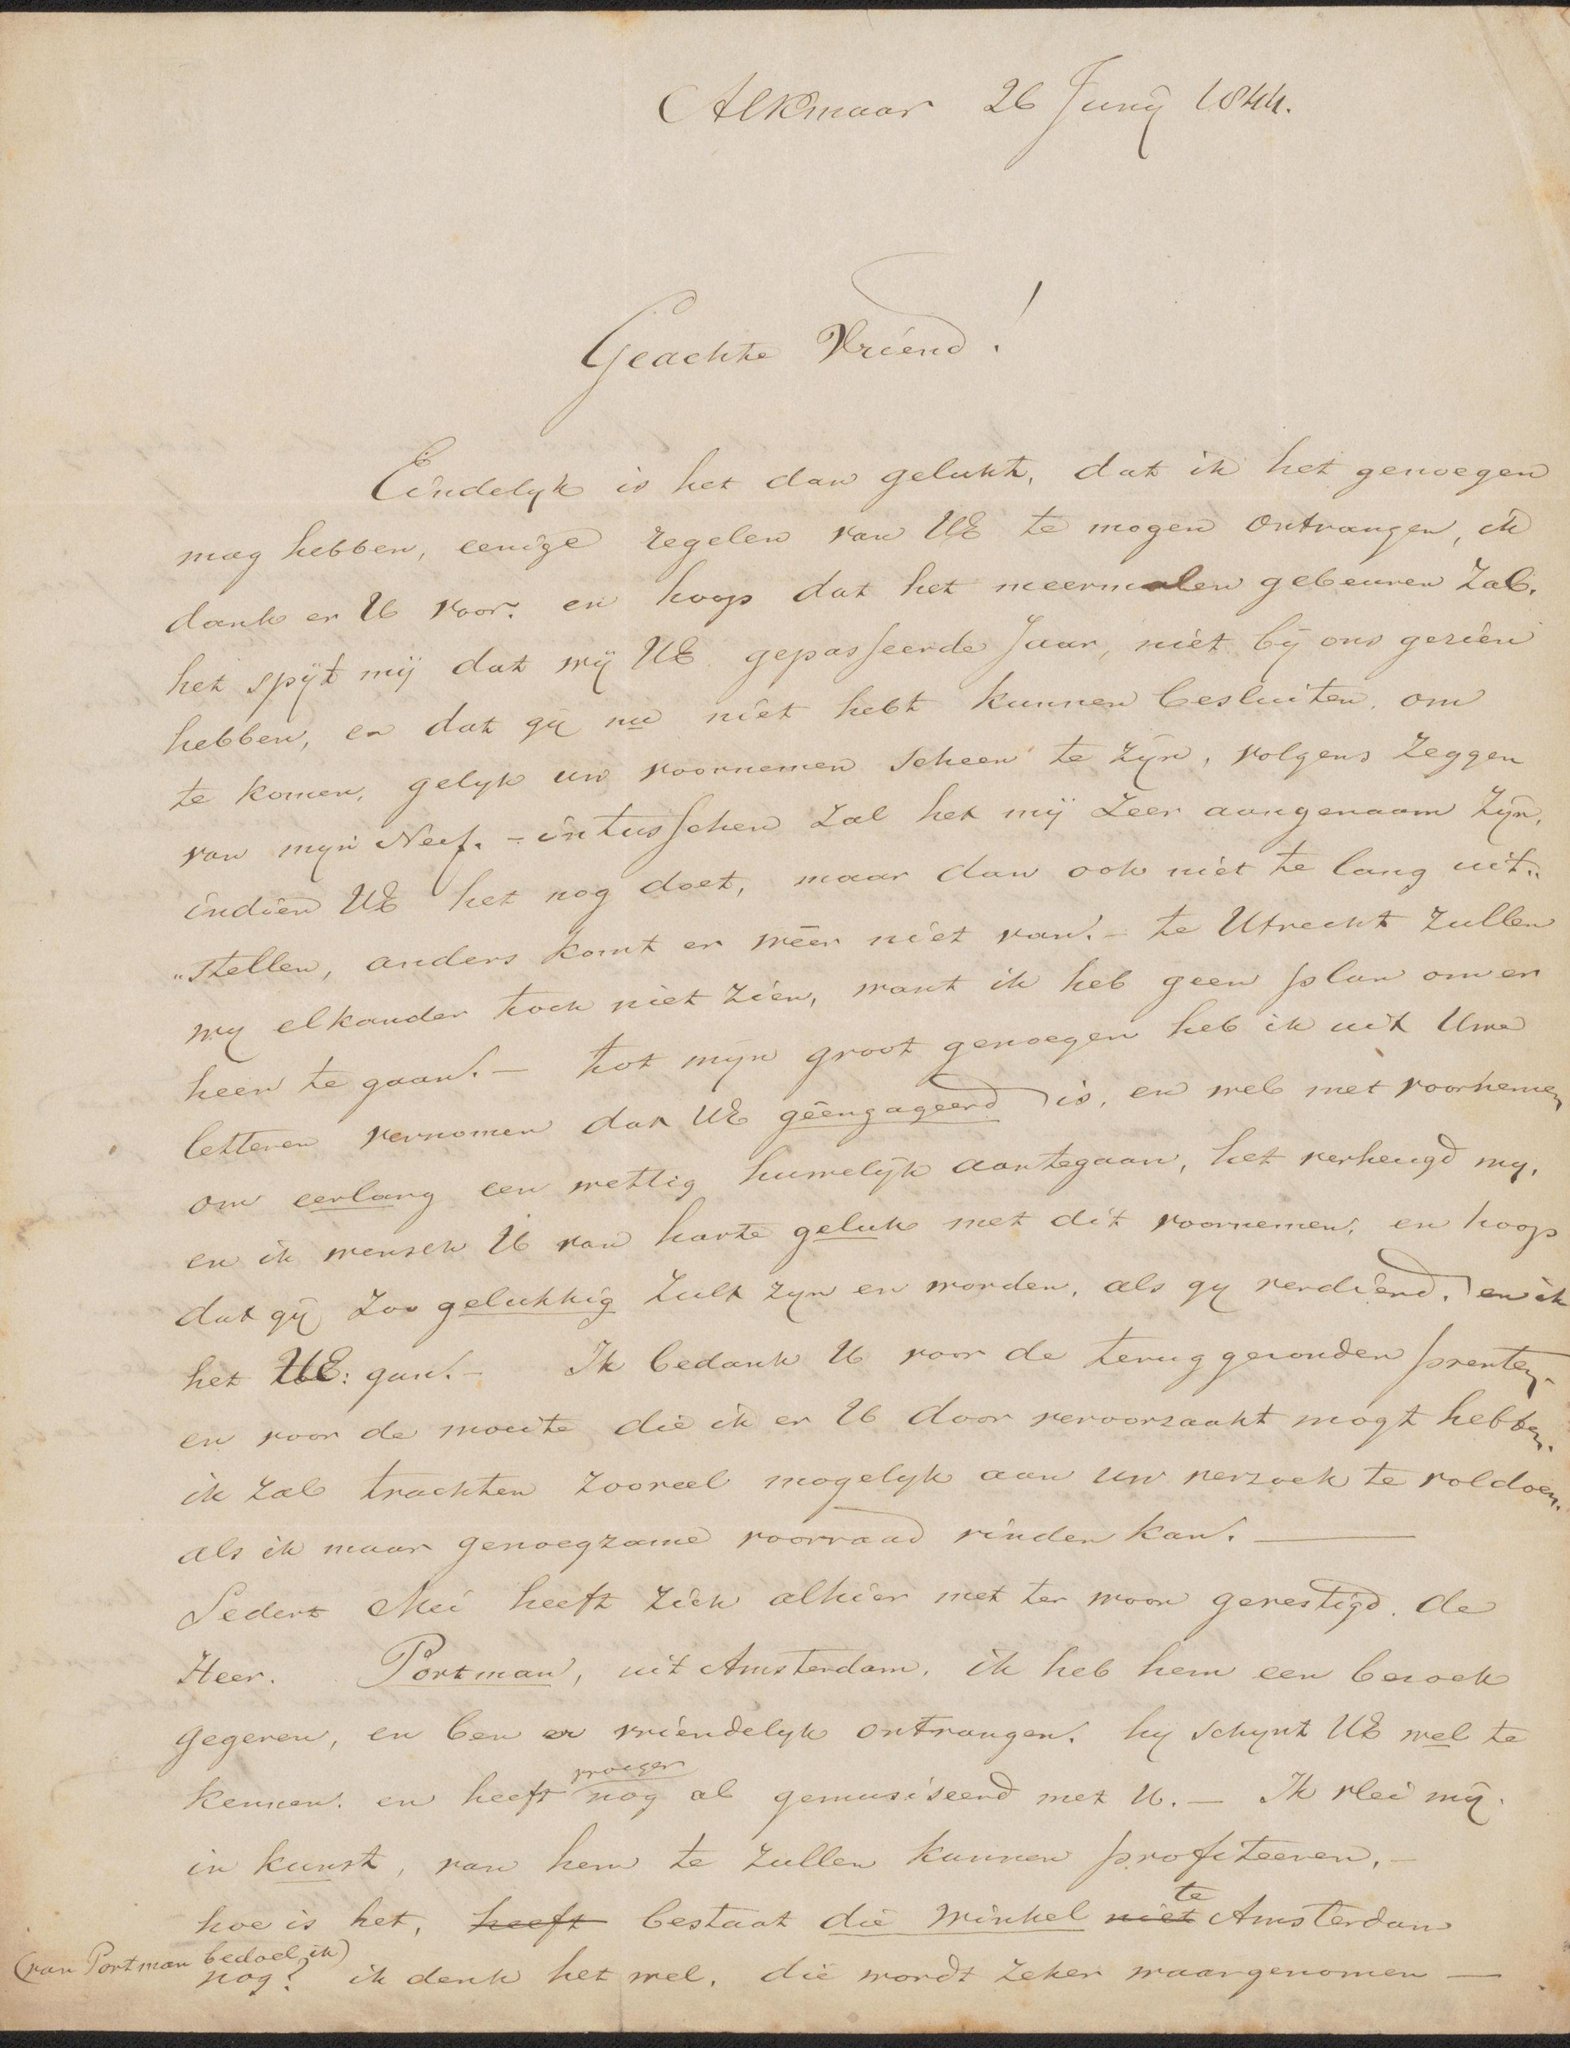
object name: letter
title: Brief aan Reinier Craeyvanger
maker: marinus jacobus stucki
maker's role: draughtsman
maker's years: 1809-1899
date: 1844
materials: ink, paper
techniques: pen, writing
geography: alkmaar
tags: christiaan julius lodewijk portman, utrecht, print maker, draughtsman, reinier craeyvanger, the graphic arts, family life, amsterdam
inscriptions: collector's mark: ‘RPK’